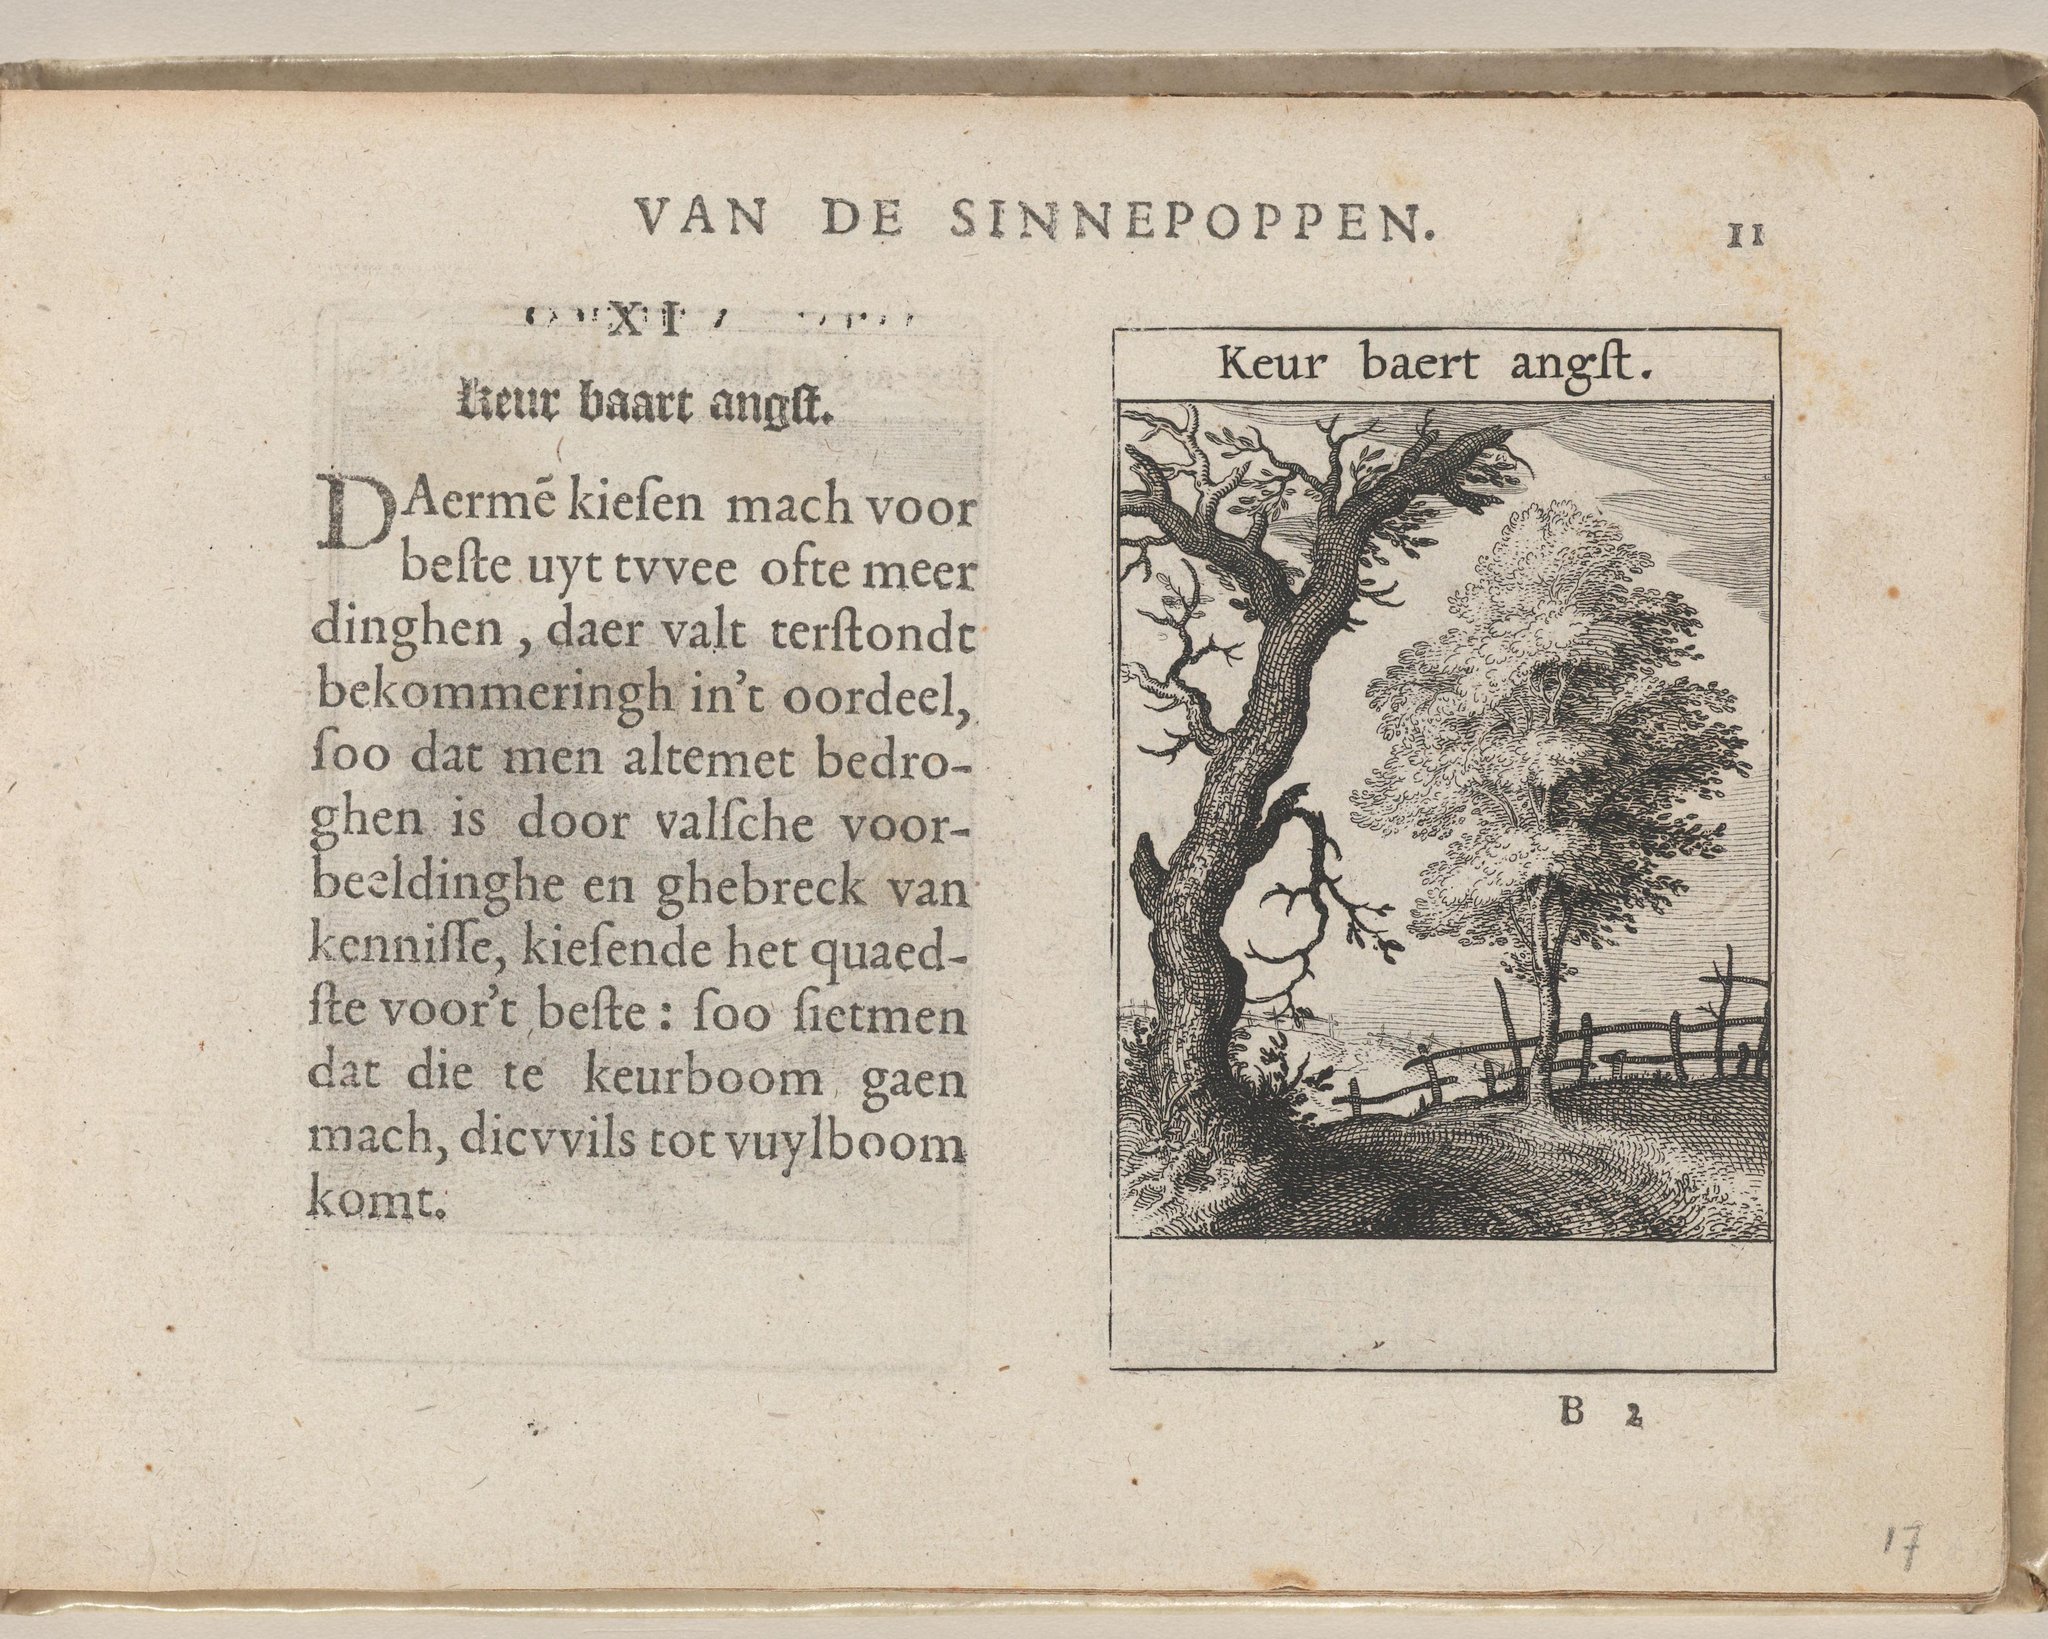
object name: print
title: XI Keur baert angst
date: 1614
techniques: engraving, printing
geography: the hague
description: XI Keur baert angst. Eerste schok. Onderdeel van 'Sinnepoppen', R. Visscher, 1614.